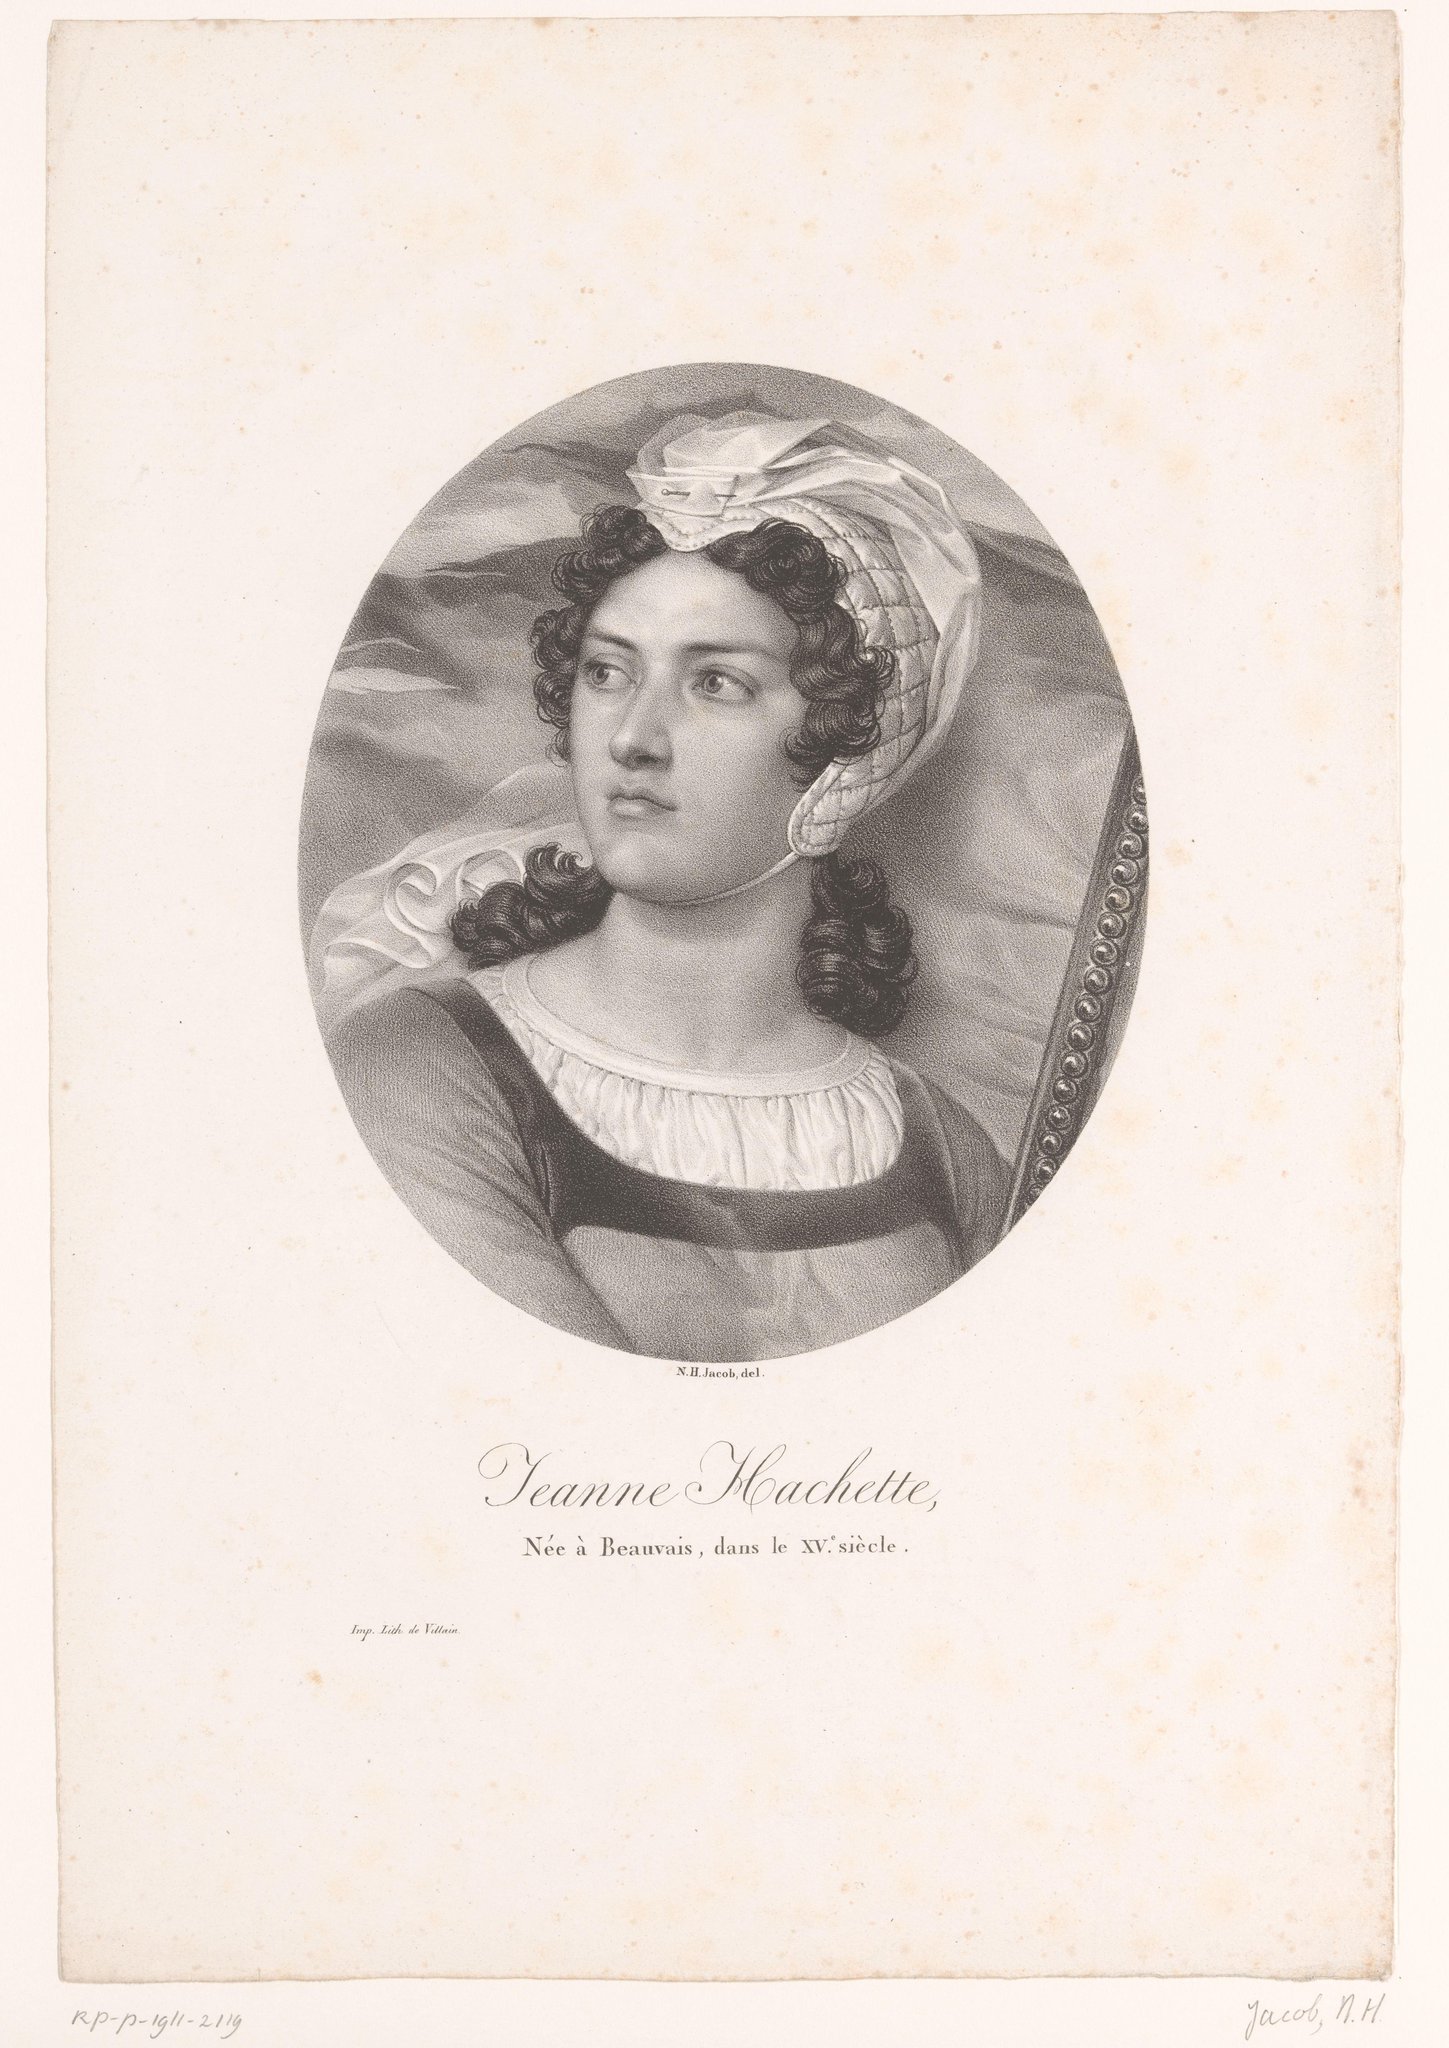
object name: print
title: Portret van Jeanne Hachette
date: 1825-1827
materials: paper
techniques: lithograph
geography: paris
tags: historical persons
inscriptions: collector's mark: Lugt 2228a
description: Prent gebruikt voor: Le Panthéon français, ou Collection de portraits des personnages célèbres (...). Parijs: P. Sudré, 1825-1827.